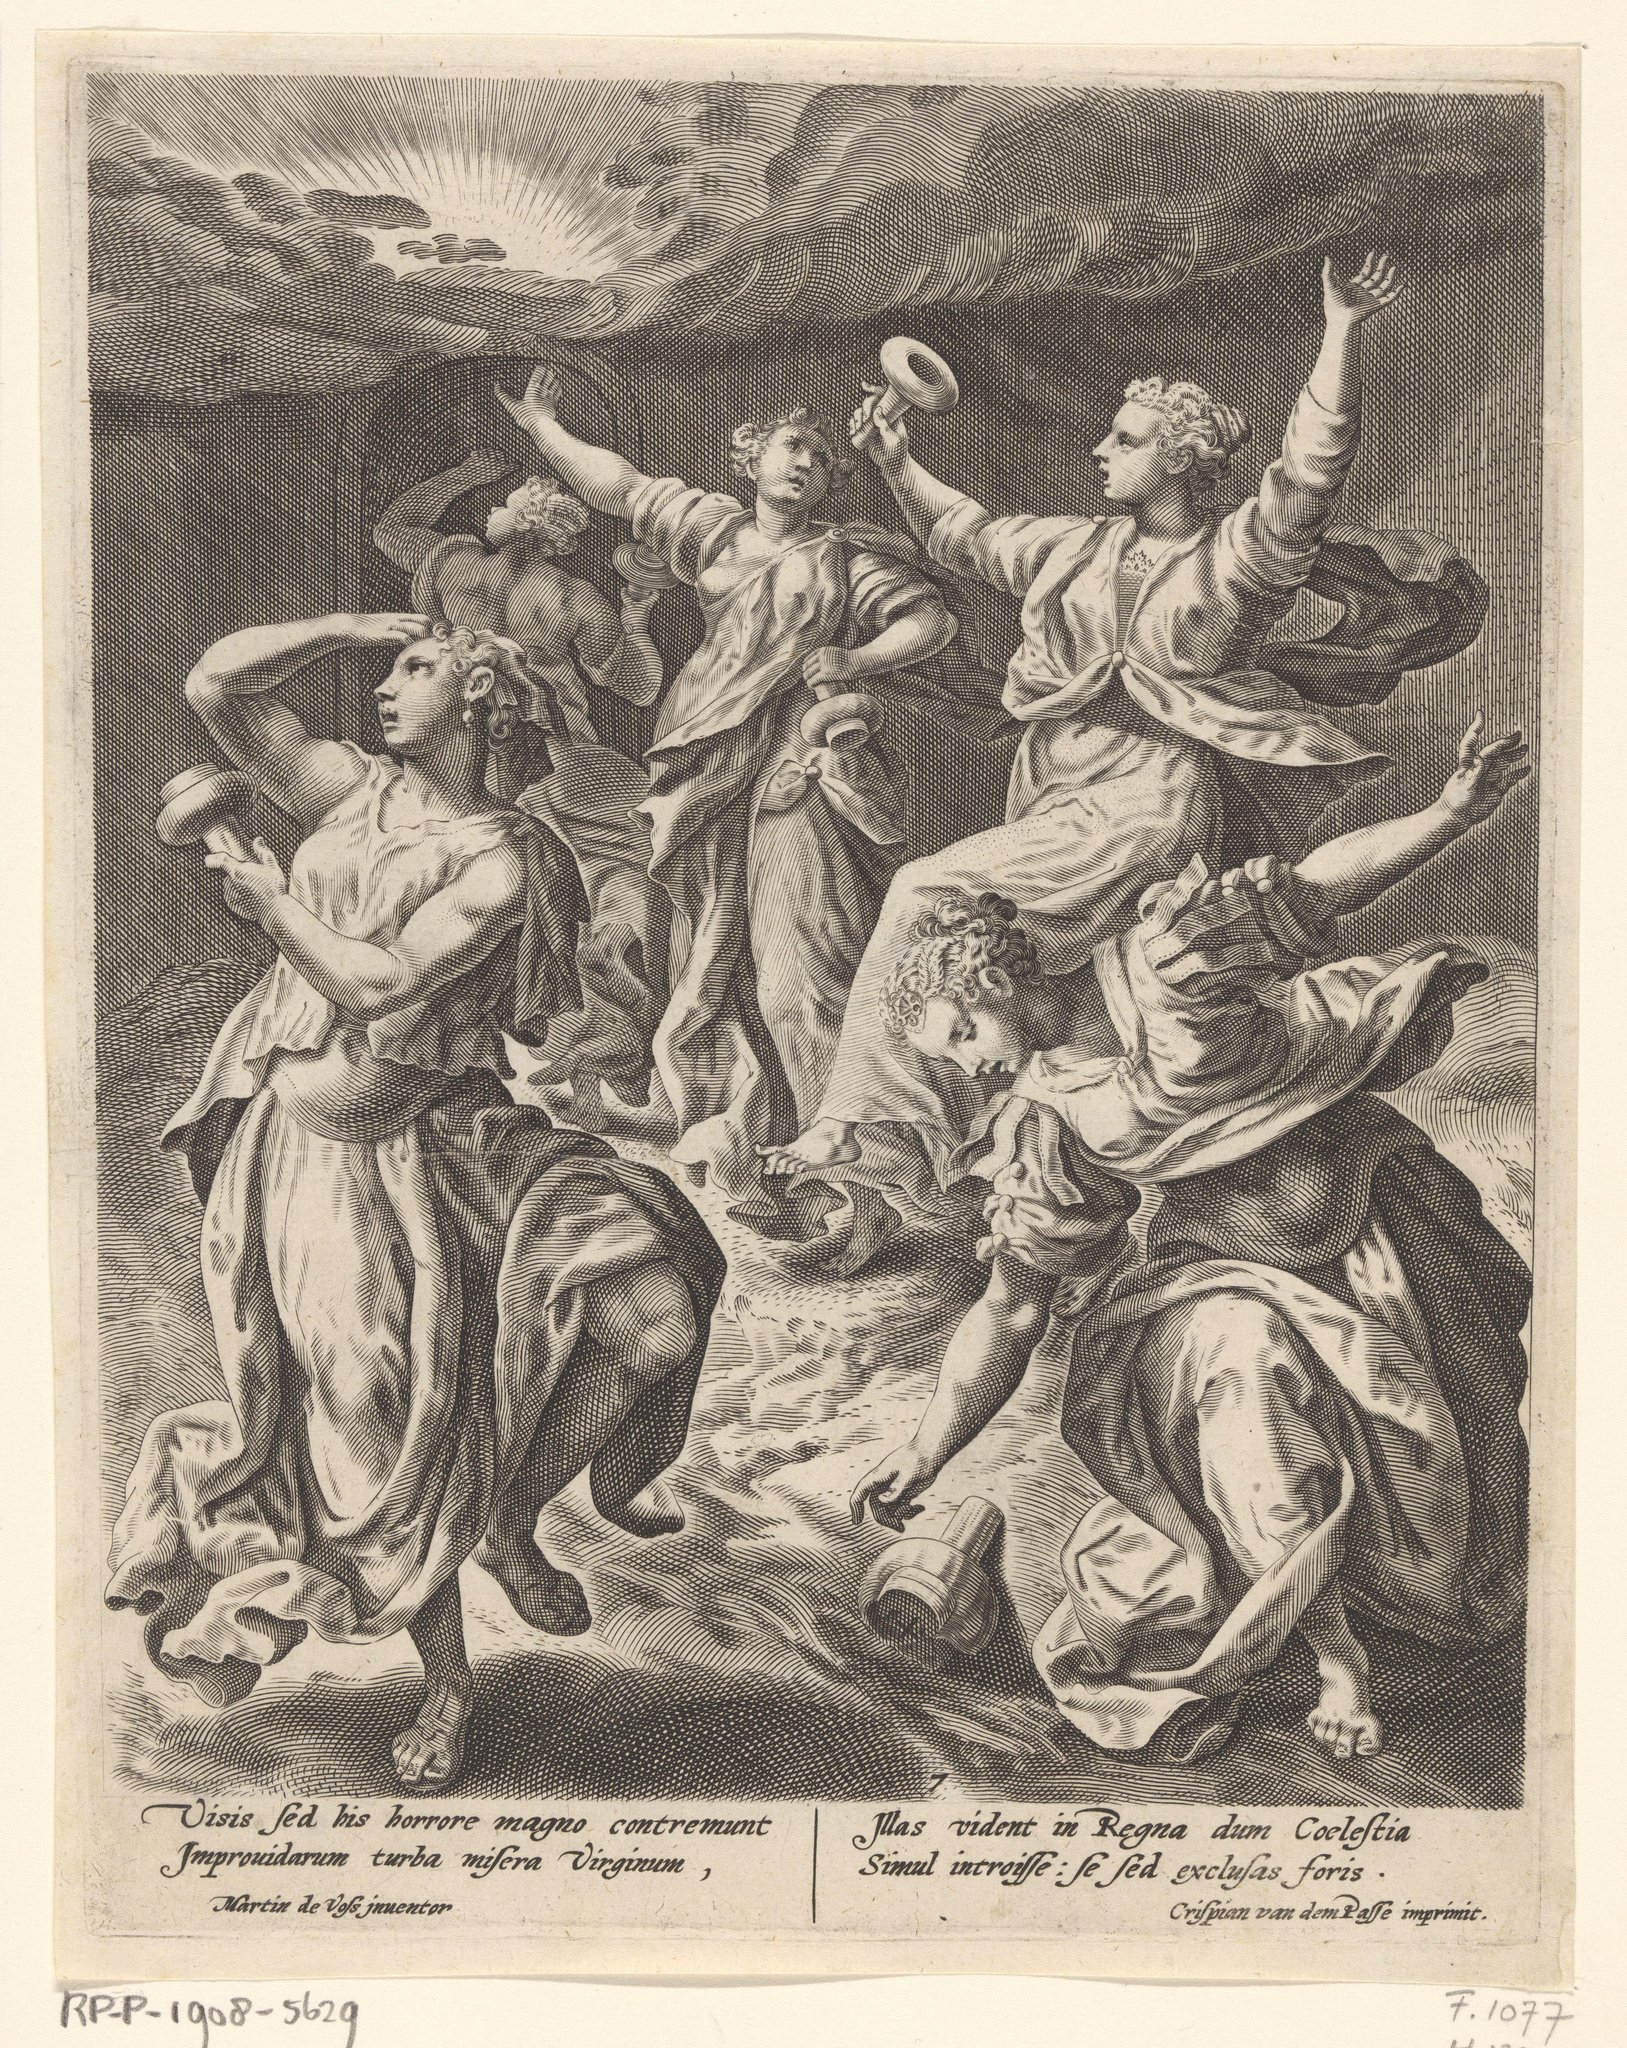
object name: print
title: De vijf dwaze maagden zijn buitengesloten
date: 1589-1611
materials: paper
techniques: engraving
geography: cologne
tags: the wise virgins are let into the house with the bridegroom (christ); the foolish virgins are shut out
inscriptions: collector's mark: Lugt 2228, collector's mark: Lugt 2161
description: De vijf dwaze maagden staan voor de gesloten deur van het huis van de bruidegom. Ze roepen om binnengelaten te worden. In de marge een vierregelig onderschrift, in twee kolommen, in het Latijn dat verwijst naar de buitengesloten maagden.